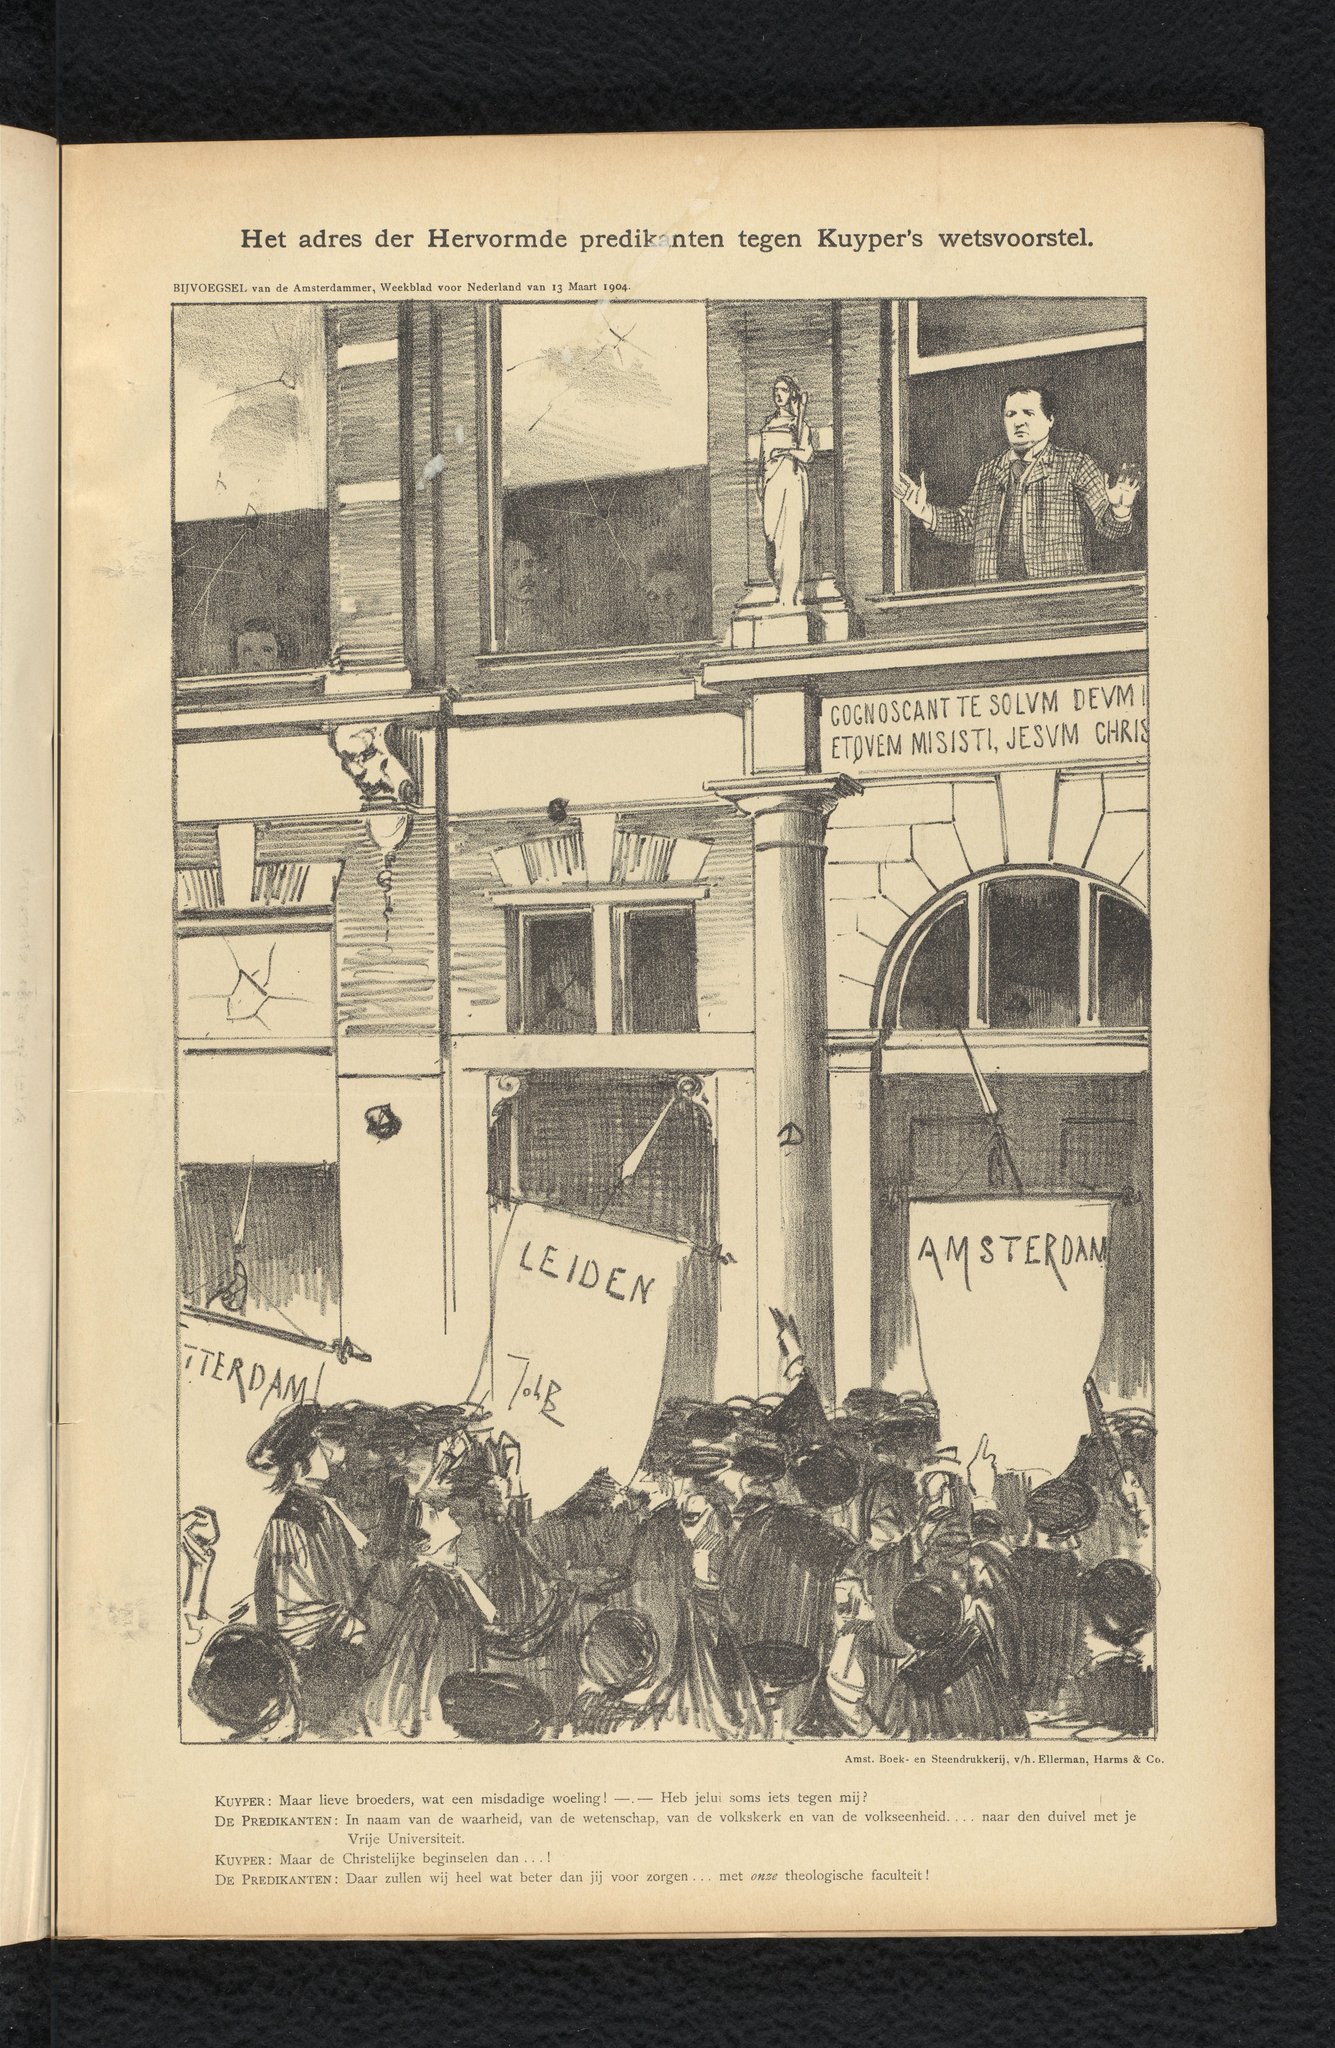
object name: cartoon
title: Het adres der Hervormde predikanten tegen Kuyper's wetsvoorstel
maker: johan braakensiek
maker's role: draughtsman, print maker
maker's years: 1858-1940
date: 1904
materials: paper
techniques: lithograph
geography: amsterdam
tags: the hague, abraham kuyper, prime minister, political demonstration, university, functionaries and dignitaries ~ protestant churches, political caricatures and satires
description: Premier Kuyper spreekt vanuit een raam op de eerste verdieping van het gebouw van de Vrije Universiteit aan de Keizersgracht 162 tegen een massa woedende hervormde predikanten uit Amsterdam, Leiden en Rotterdam, beneden op straat die boos zijn over de universiteit.